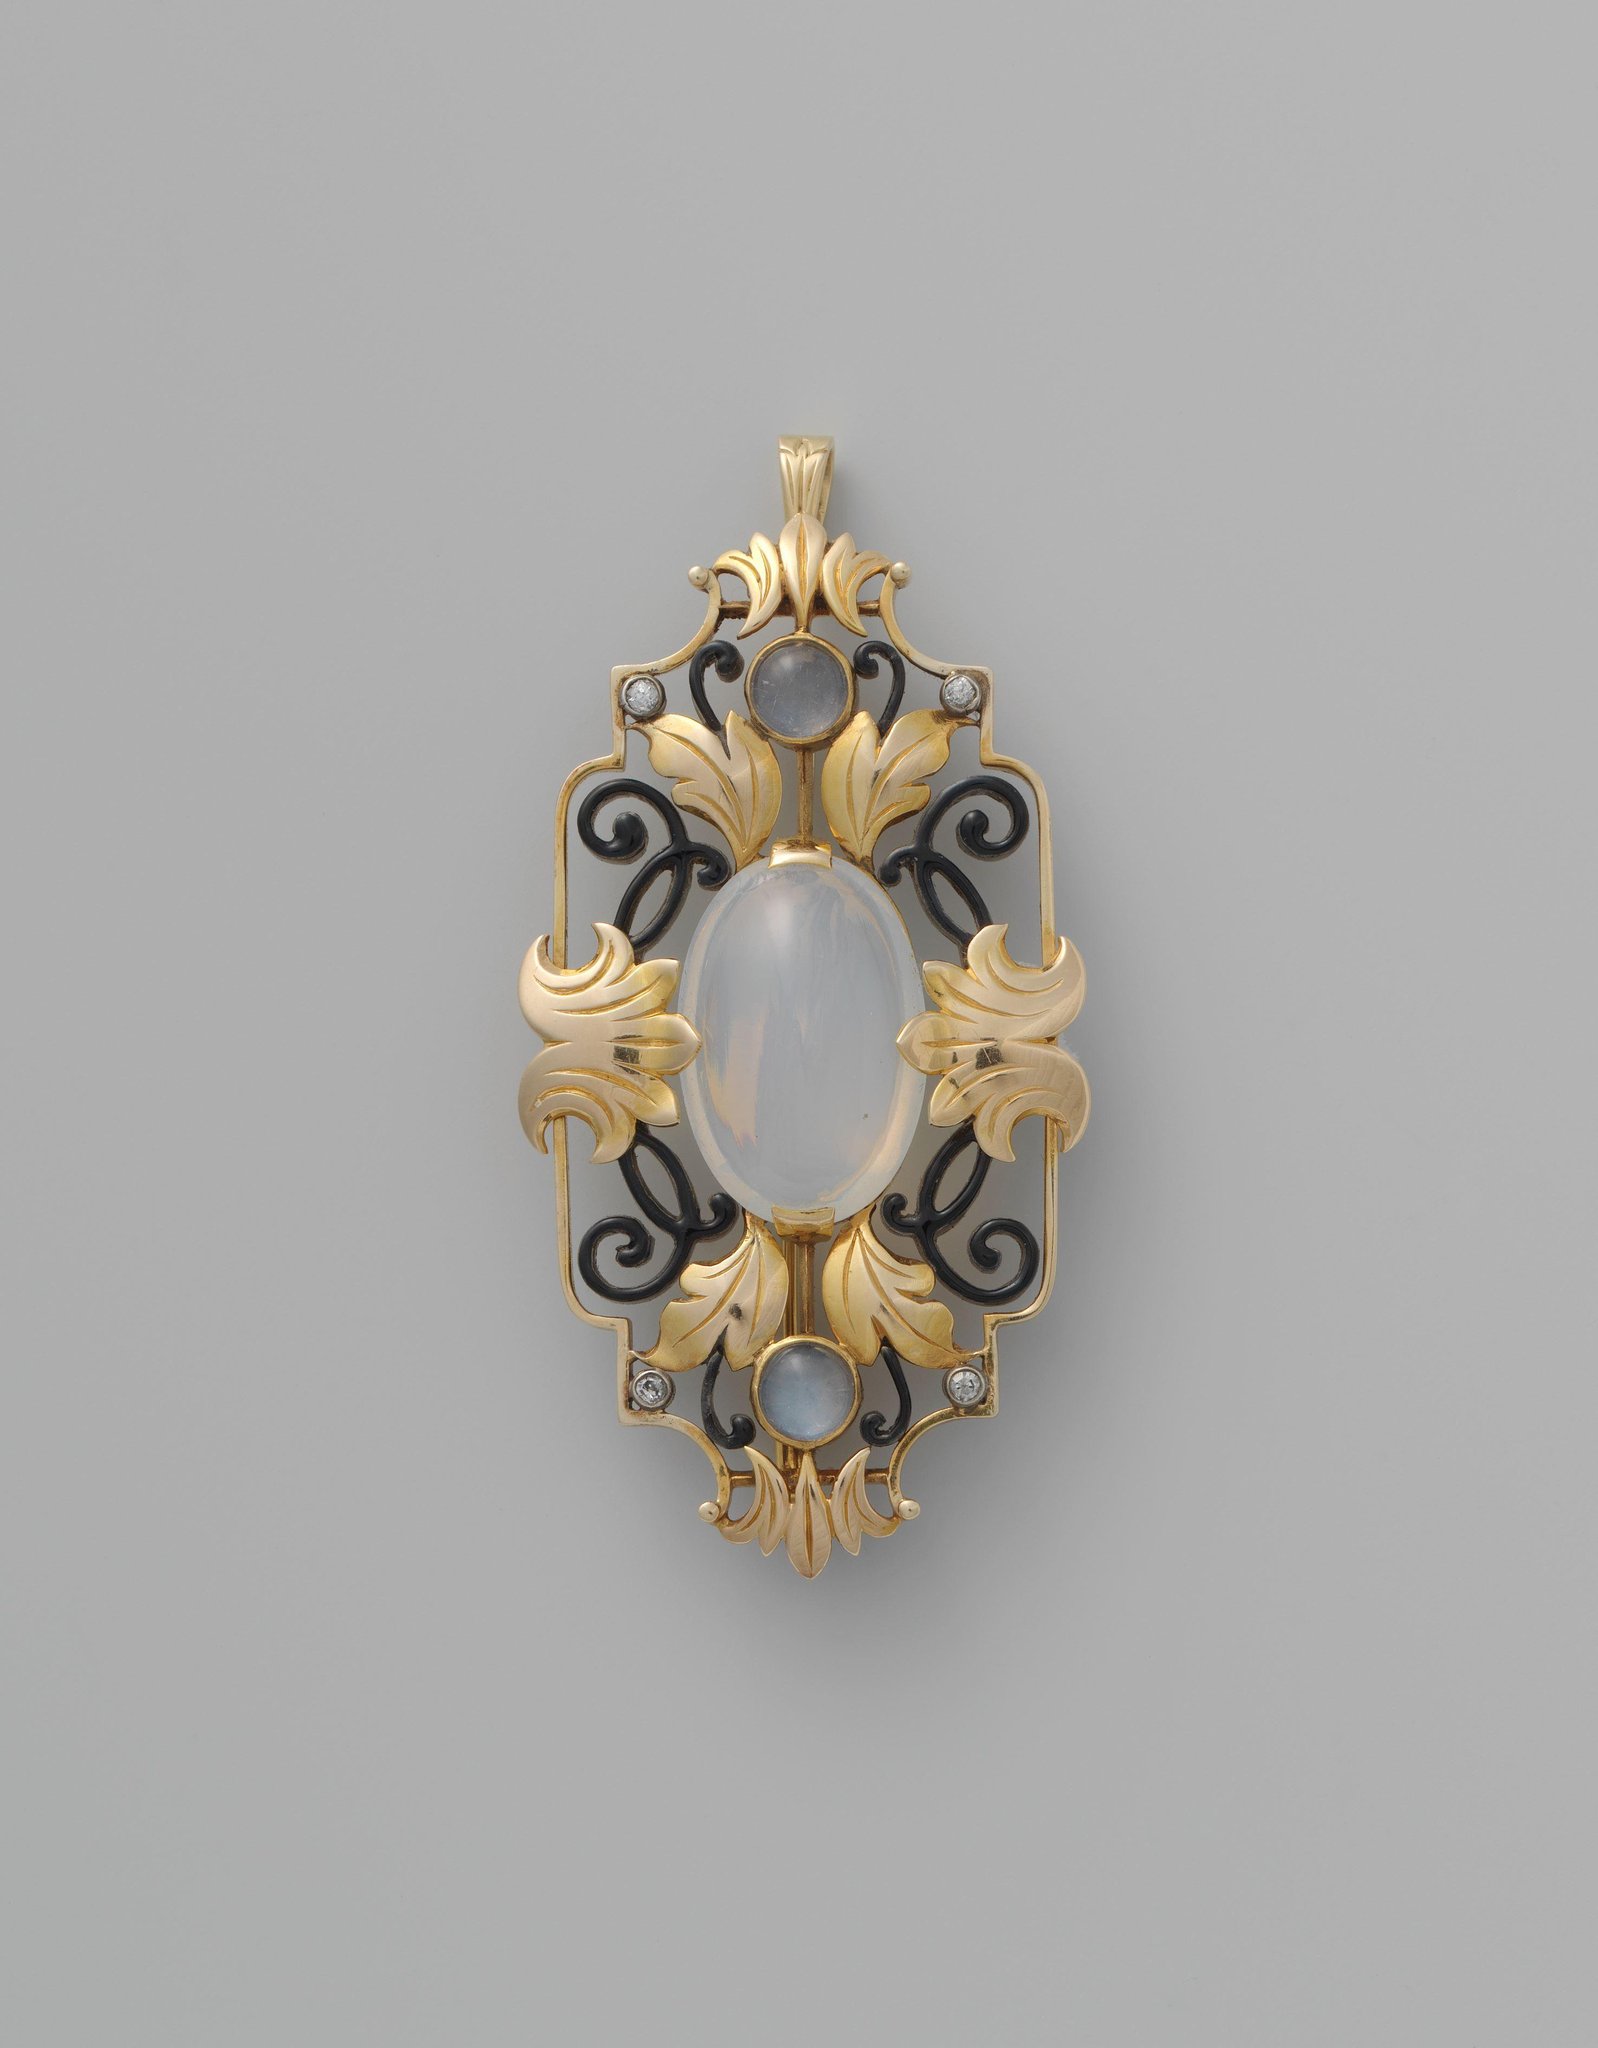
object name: brooch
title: Broche à double usage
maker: w. röhrig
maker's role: juwelier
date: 1935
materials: diamond, gold, mineral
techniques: grinding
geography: the hague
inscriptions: alloy mark: ‘(oud) eikenblad’, maker's mark: ‘WR1’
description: Broche ook te gebruiken als hanger van goud met ovale cabochon geslepen maansteen in het midden, daaromheen vier diamanten (oud slijpsel), twee ronde cabochon geslepen maanstenen en zwart email, voorzien van een vallend plaatoog. De speld heeft een kogelsluiting.